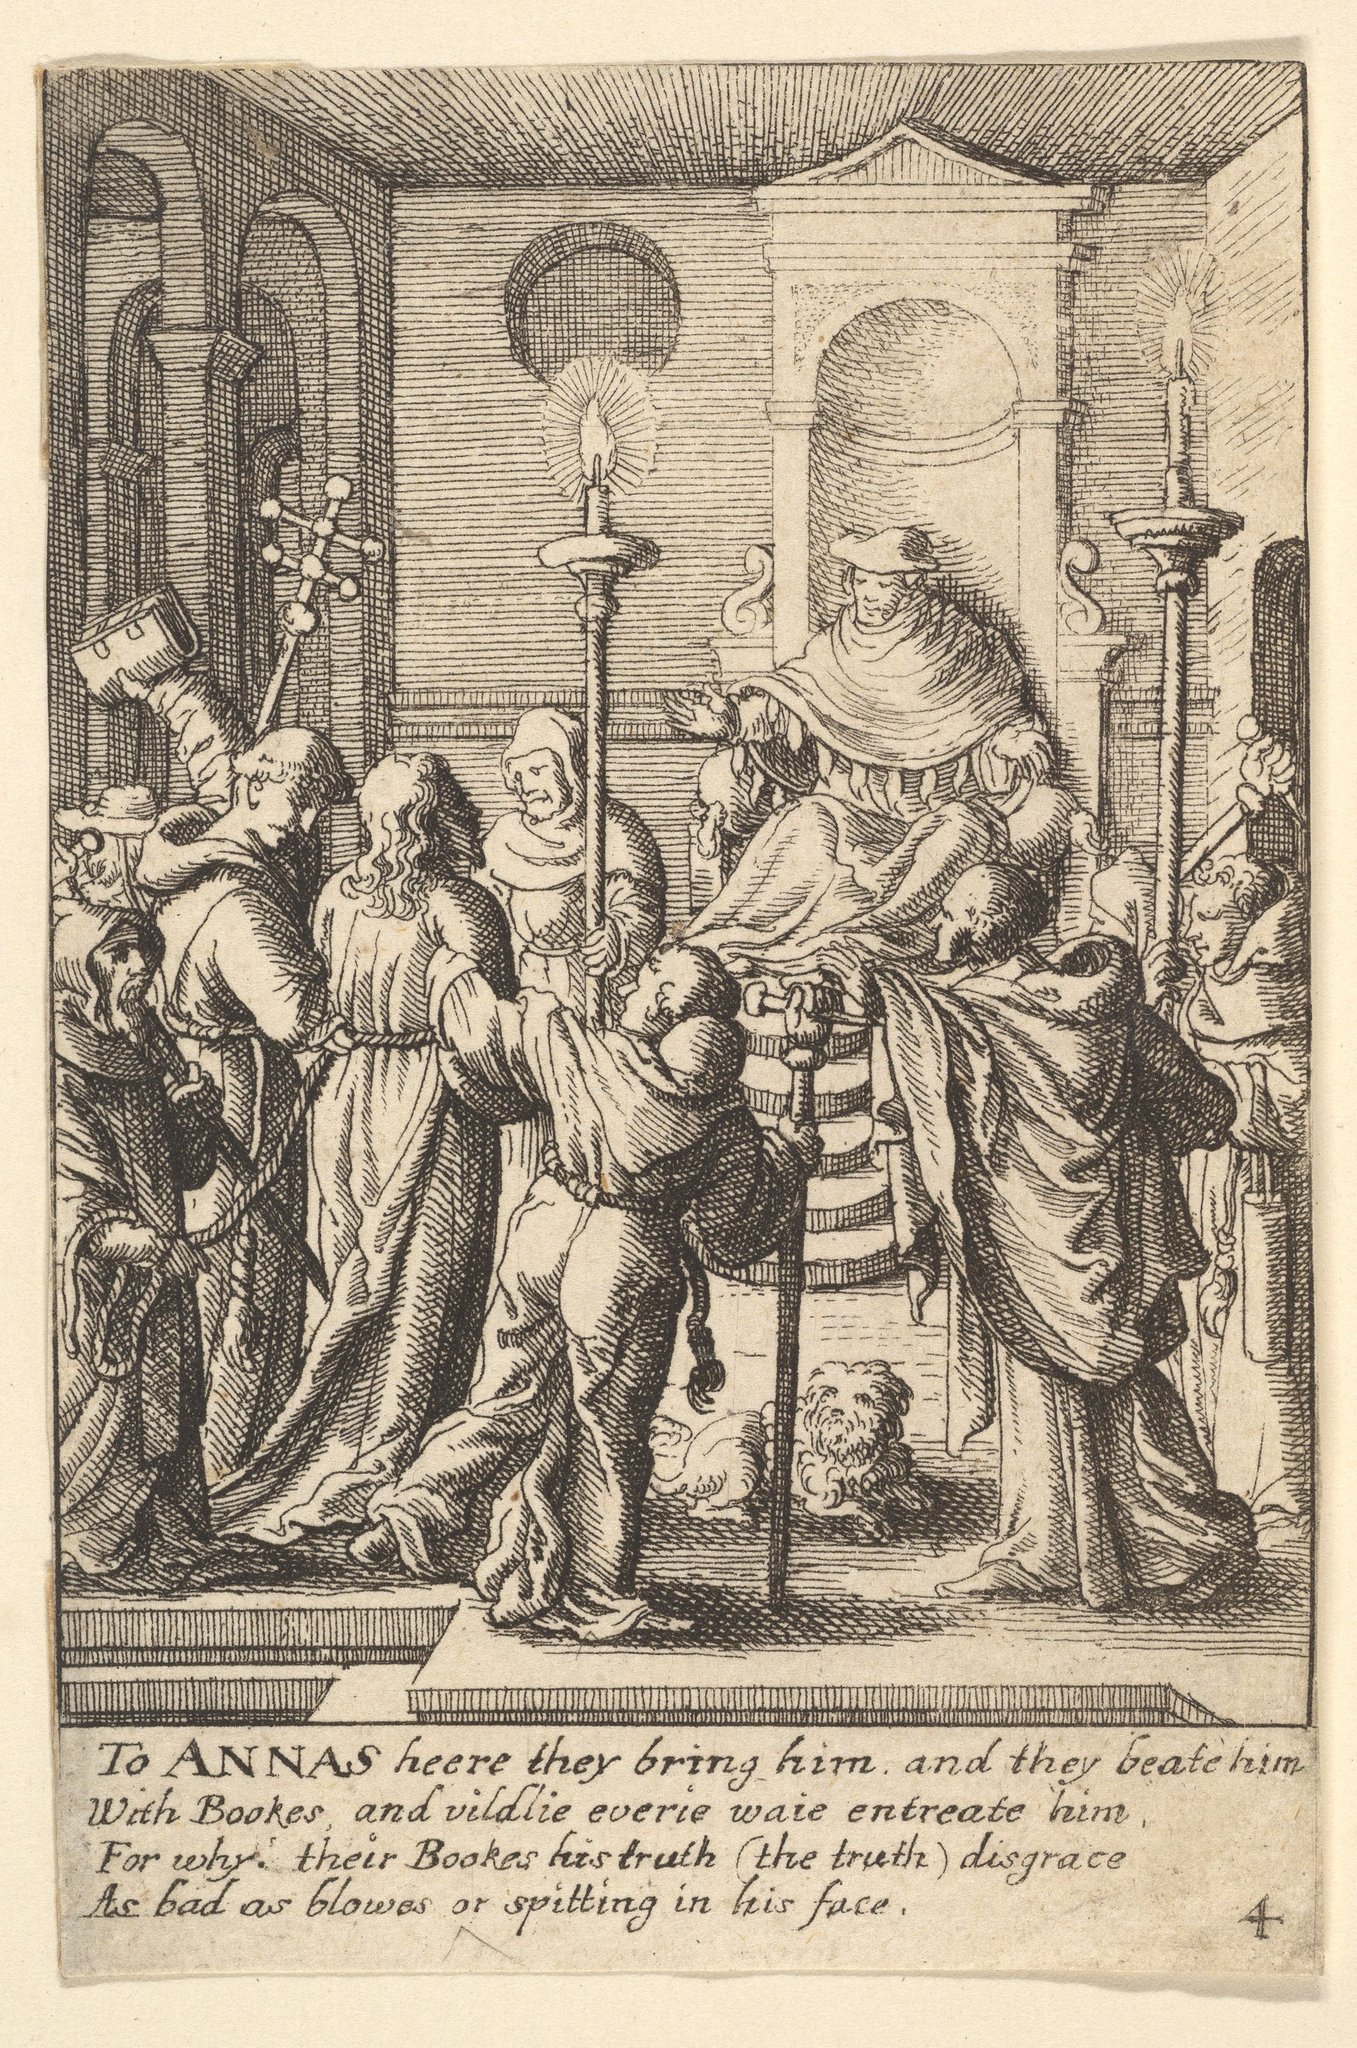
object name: print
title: Jesus before Annas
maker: wenceslaus hollar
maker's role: artist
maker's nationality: bohemian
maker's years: 1607-1677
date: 1644-1652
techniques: etching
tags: books,interiors,men,dogs,jesus,allegory